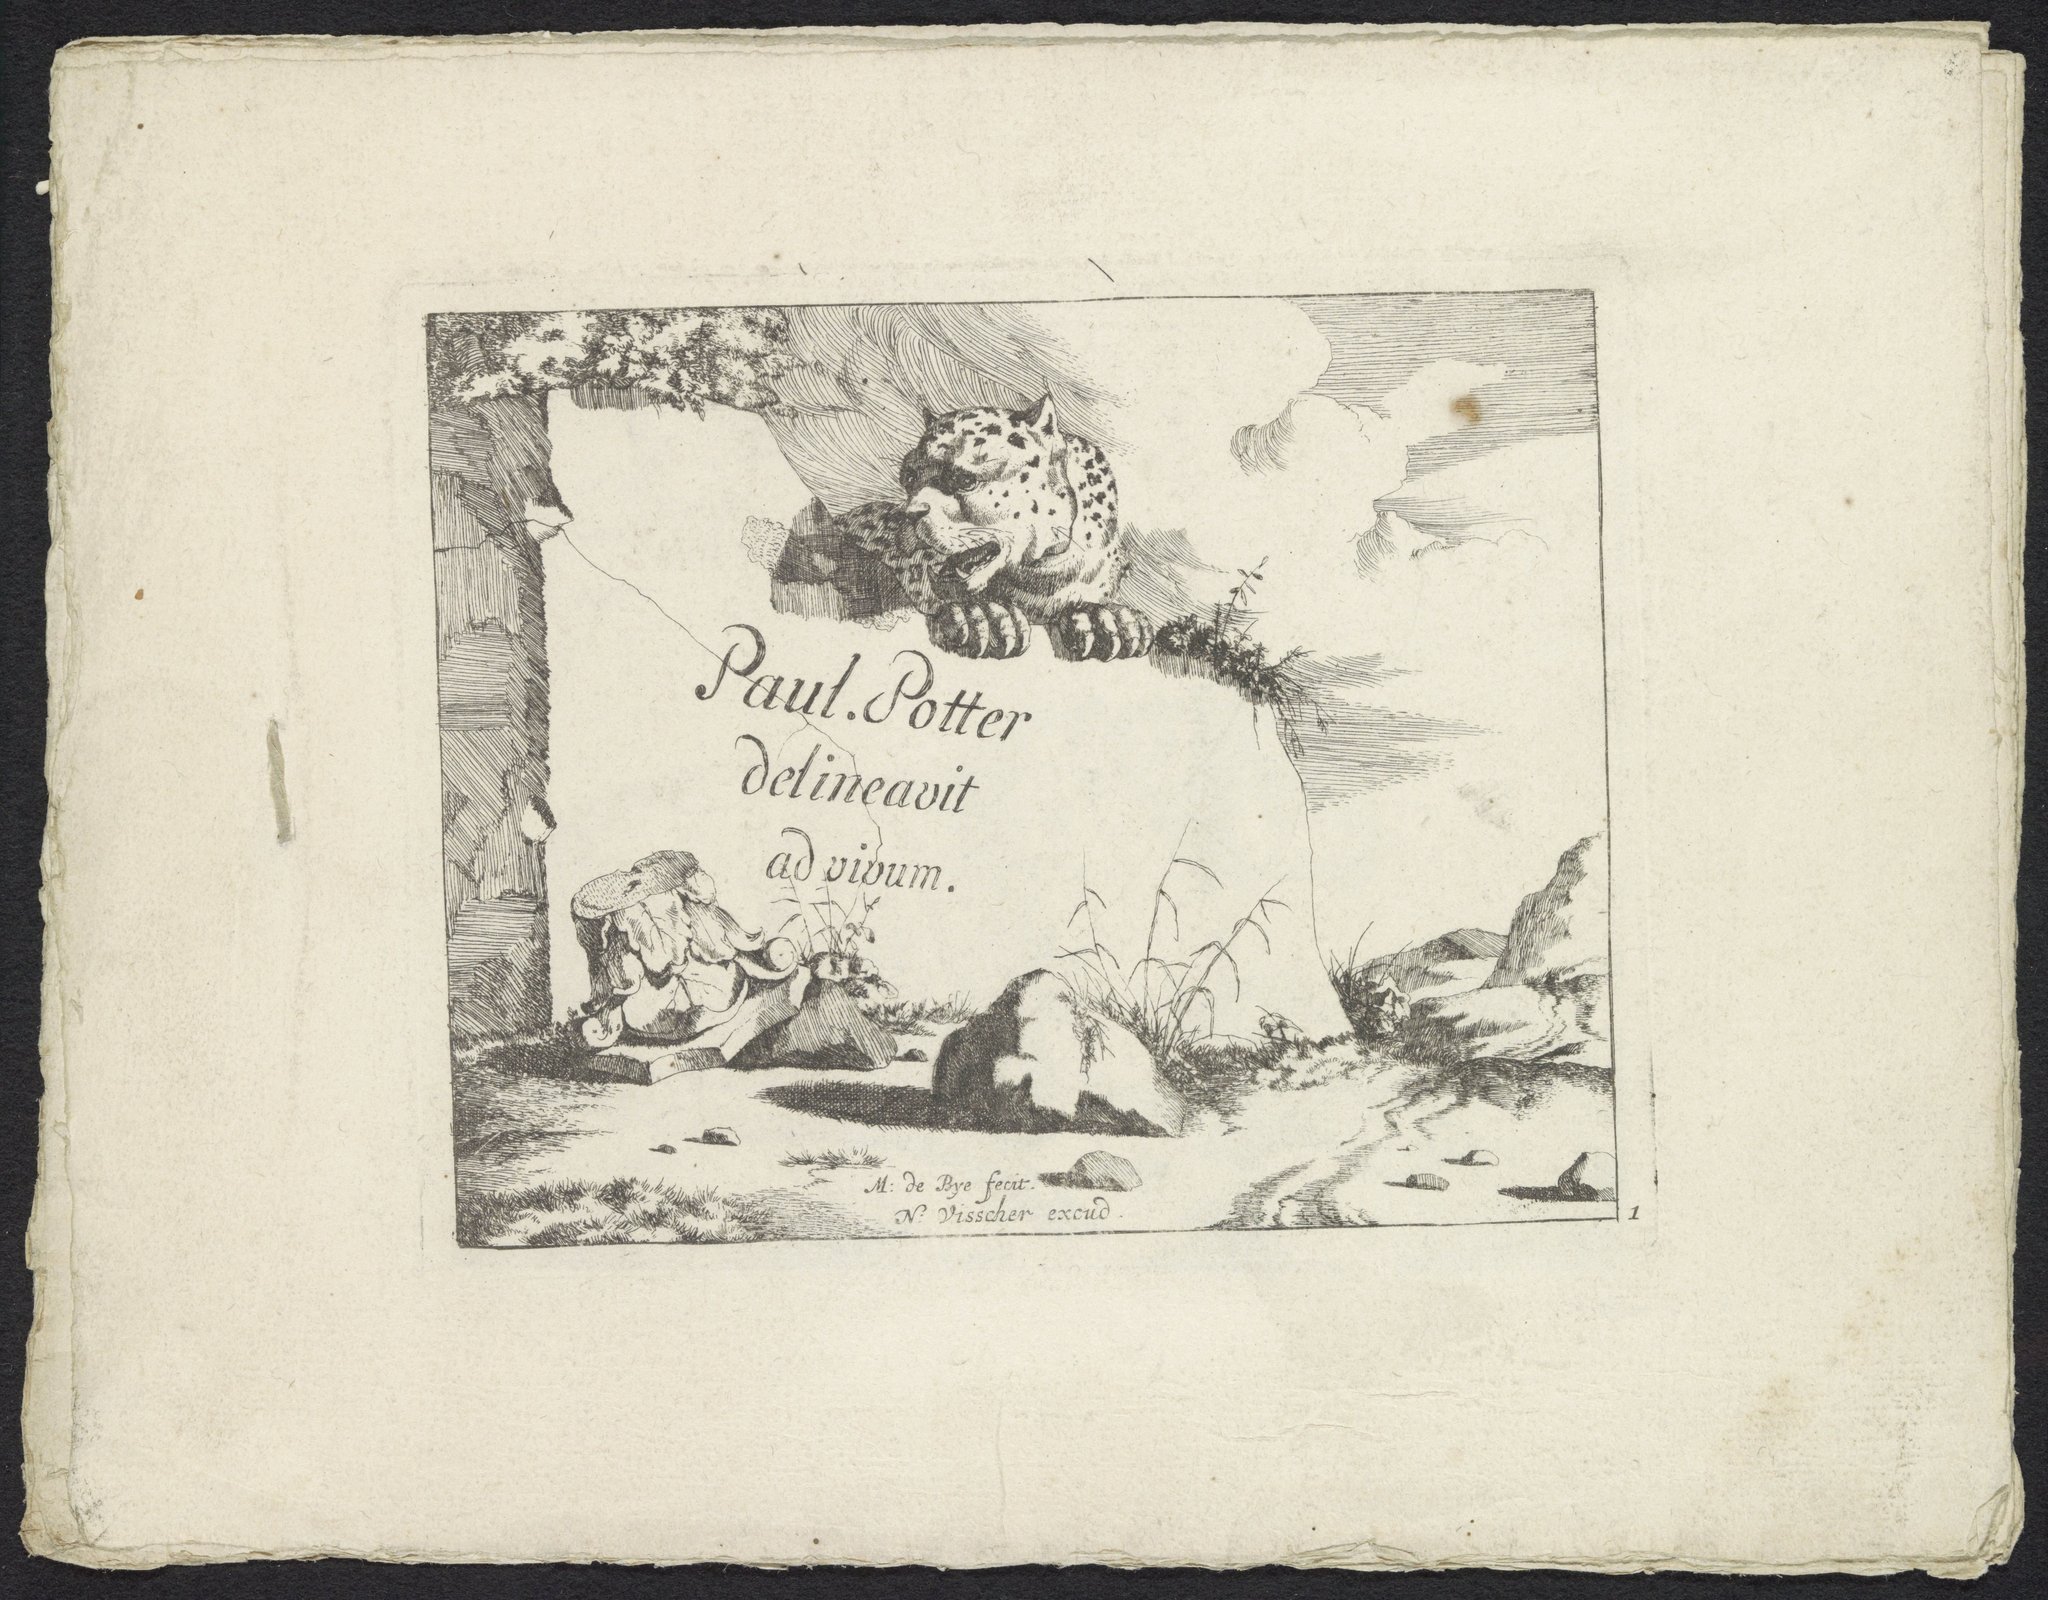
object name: print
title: Titelprent met luipaard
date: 1657-1677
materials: paper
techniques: etching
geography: amsterdam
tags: beasts of prey, predatory animals: leopard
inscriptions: collector's mark: Lugt 2228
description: Titelprent met een luipaard achter een rots. Titelprent van een serie van acht genummerde prenten met ''naar het leven'' getekende luipaarden, de reeks aan bindtouw.